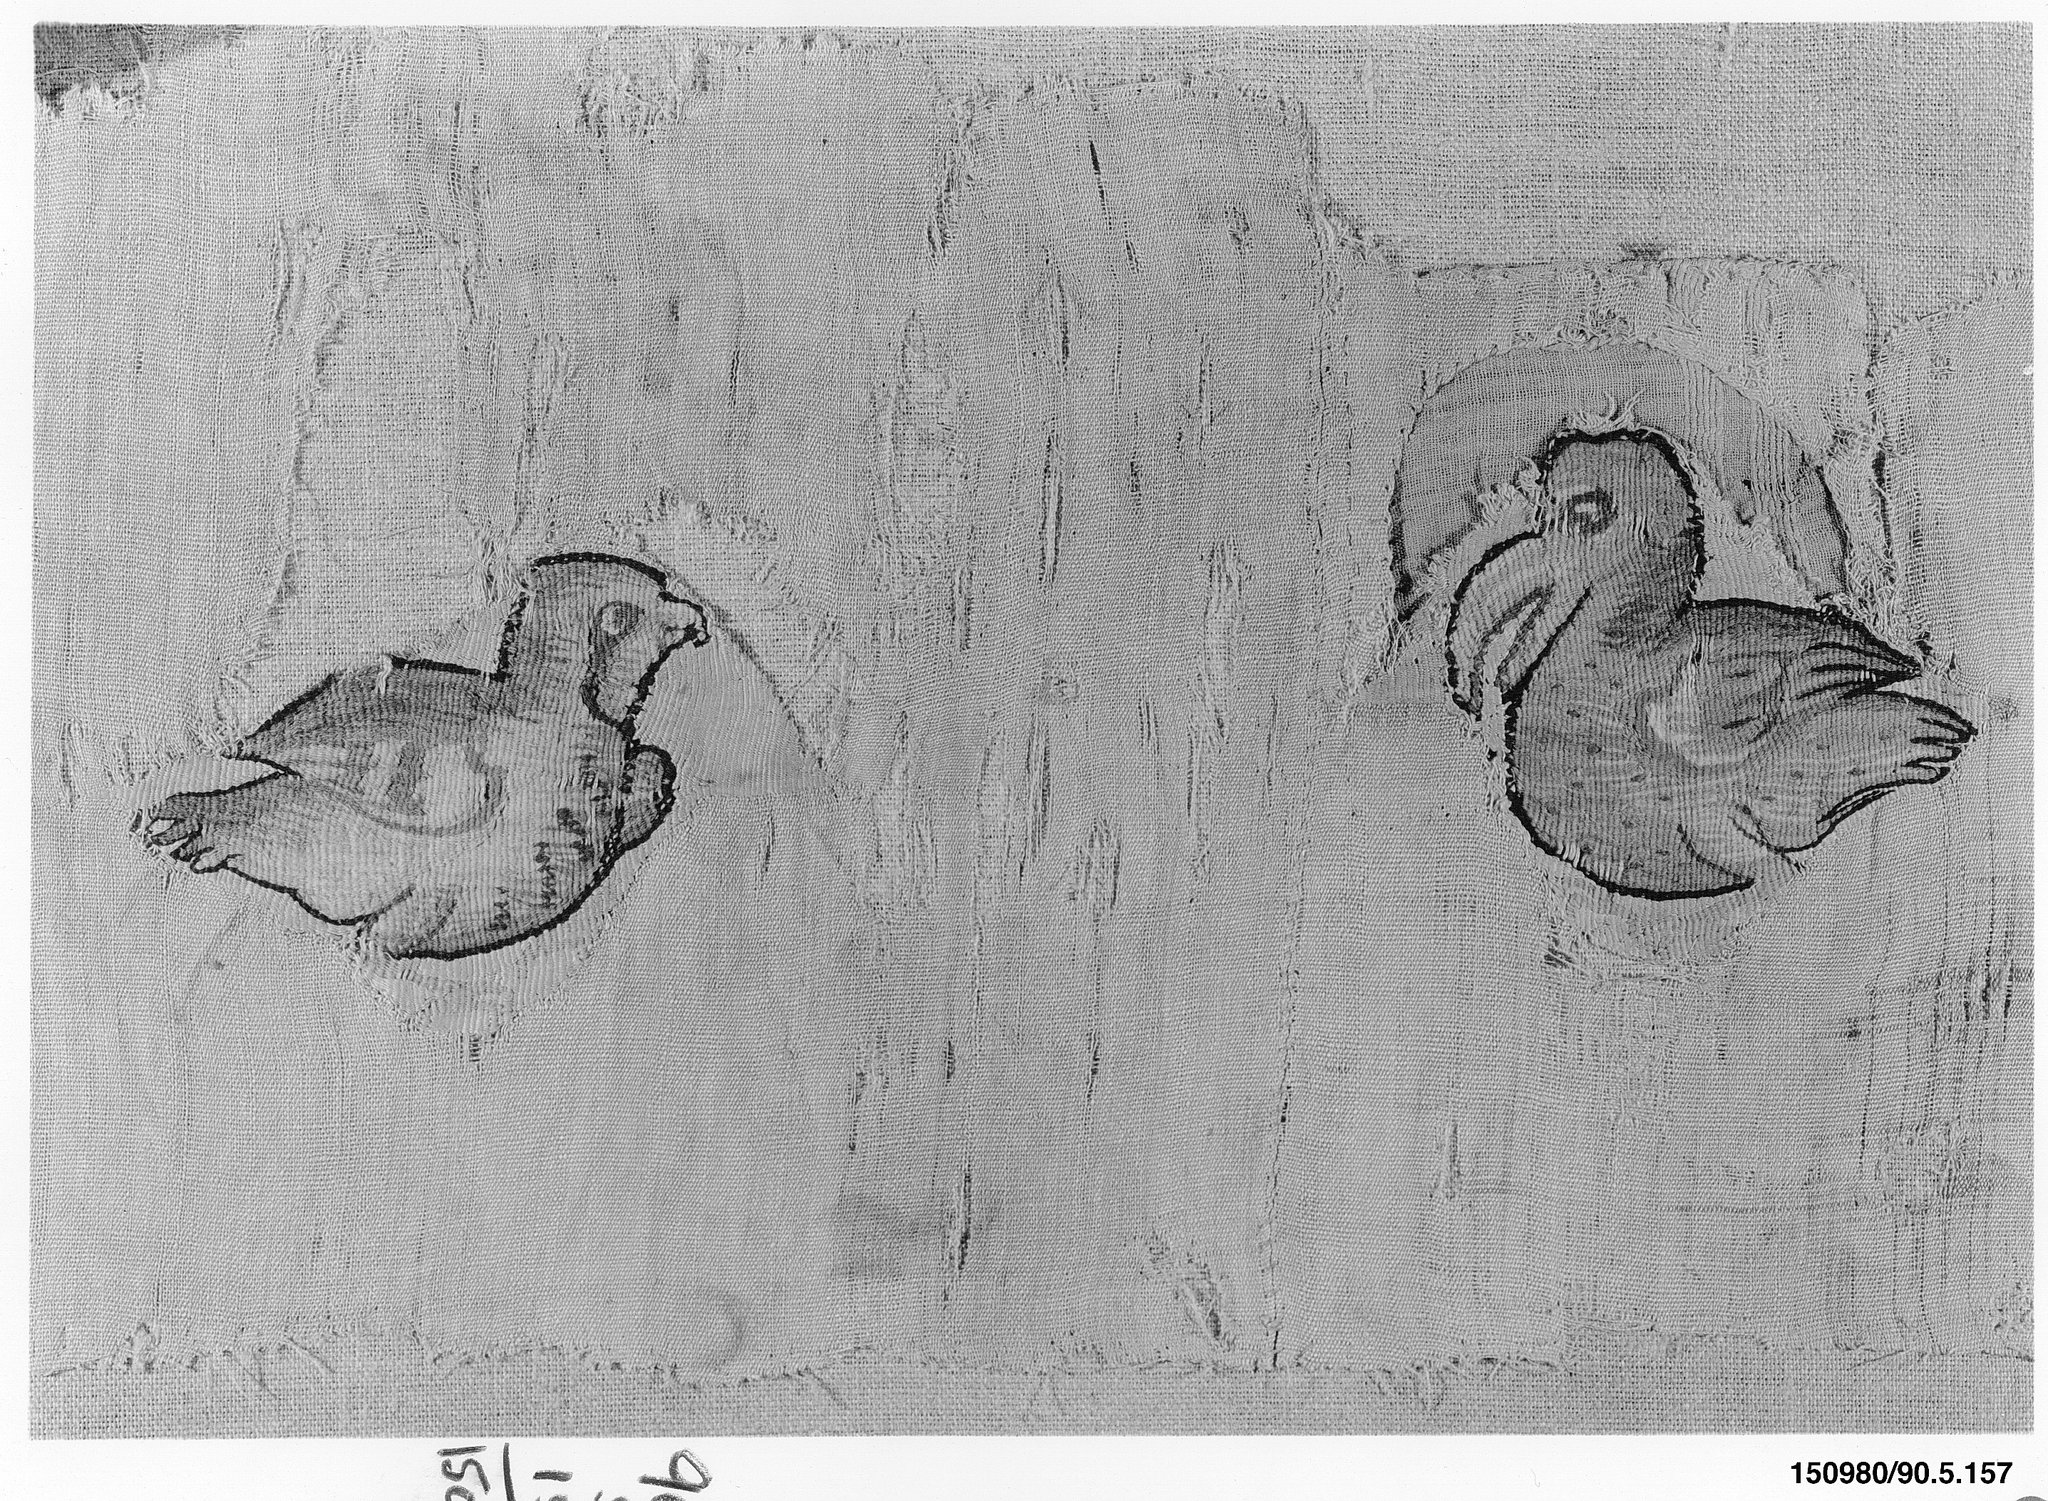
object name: textile fragment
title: Fragment with Two Birds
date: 201-300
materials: linen, wool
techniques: weave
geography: egypt